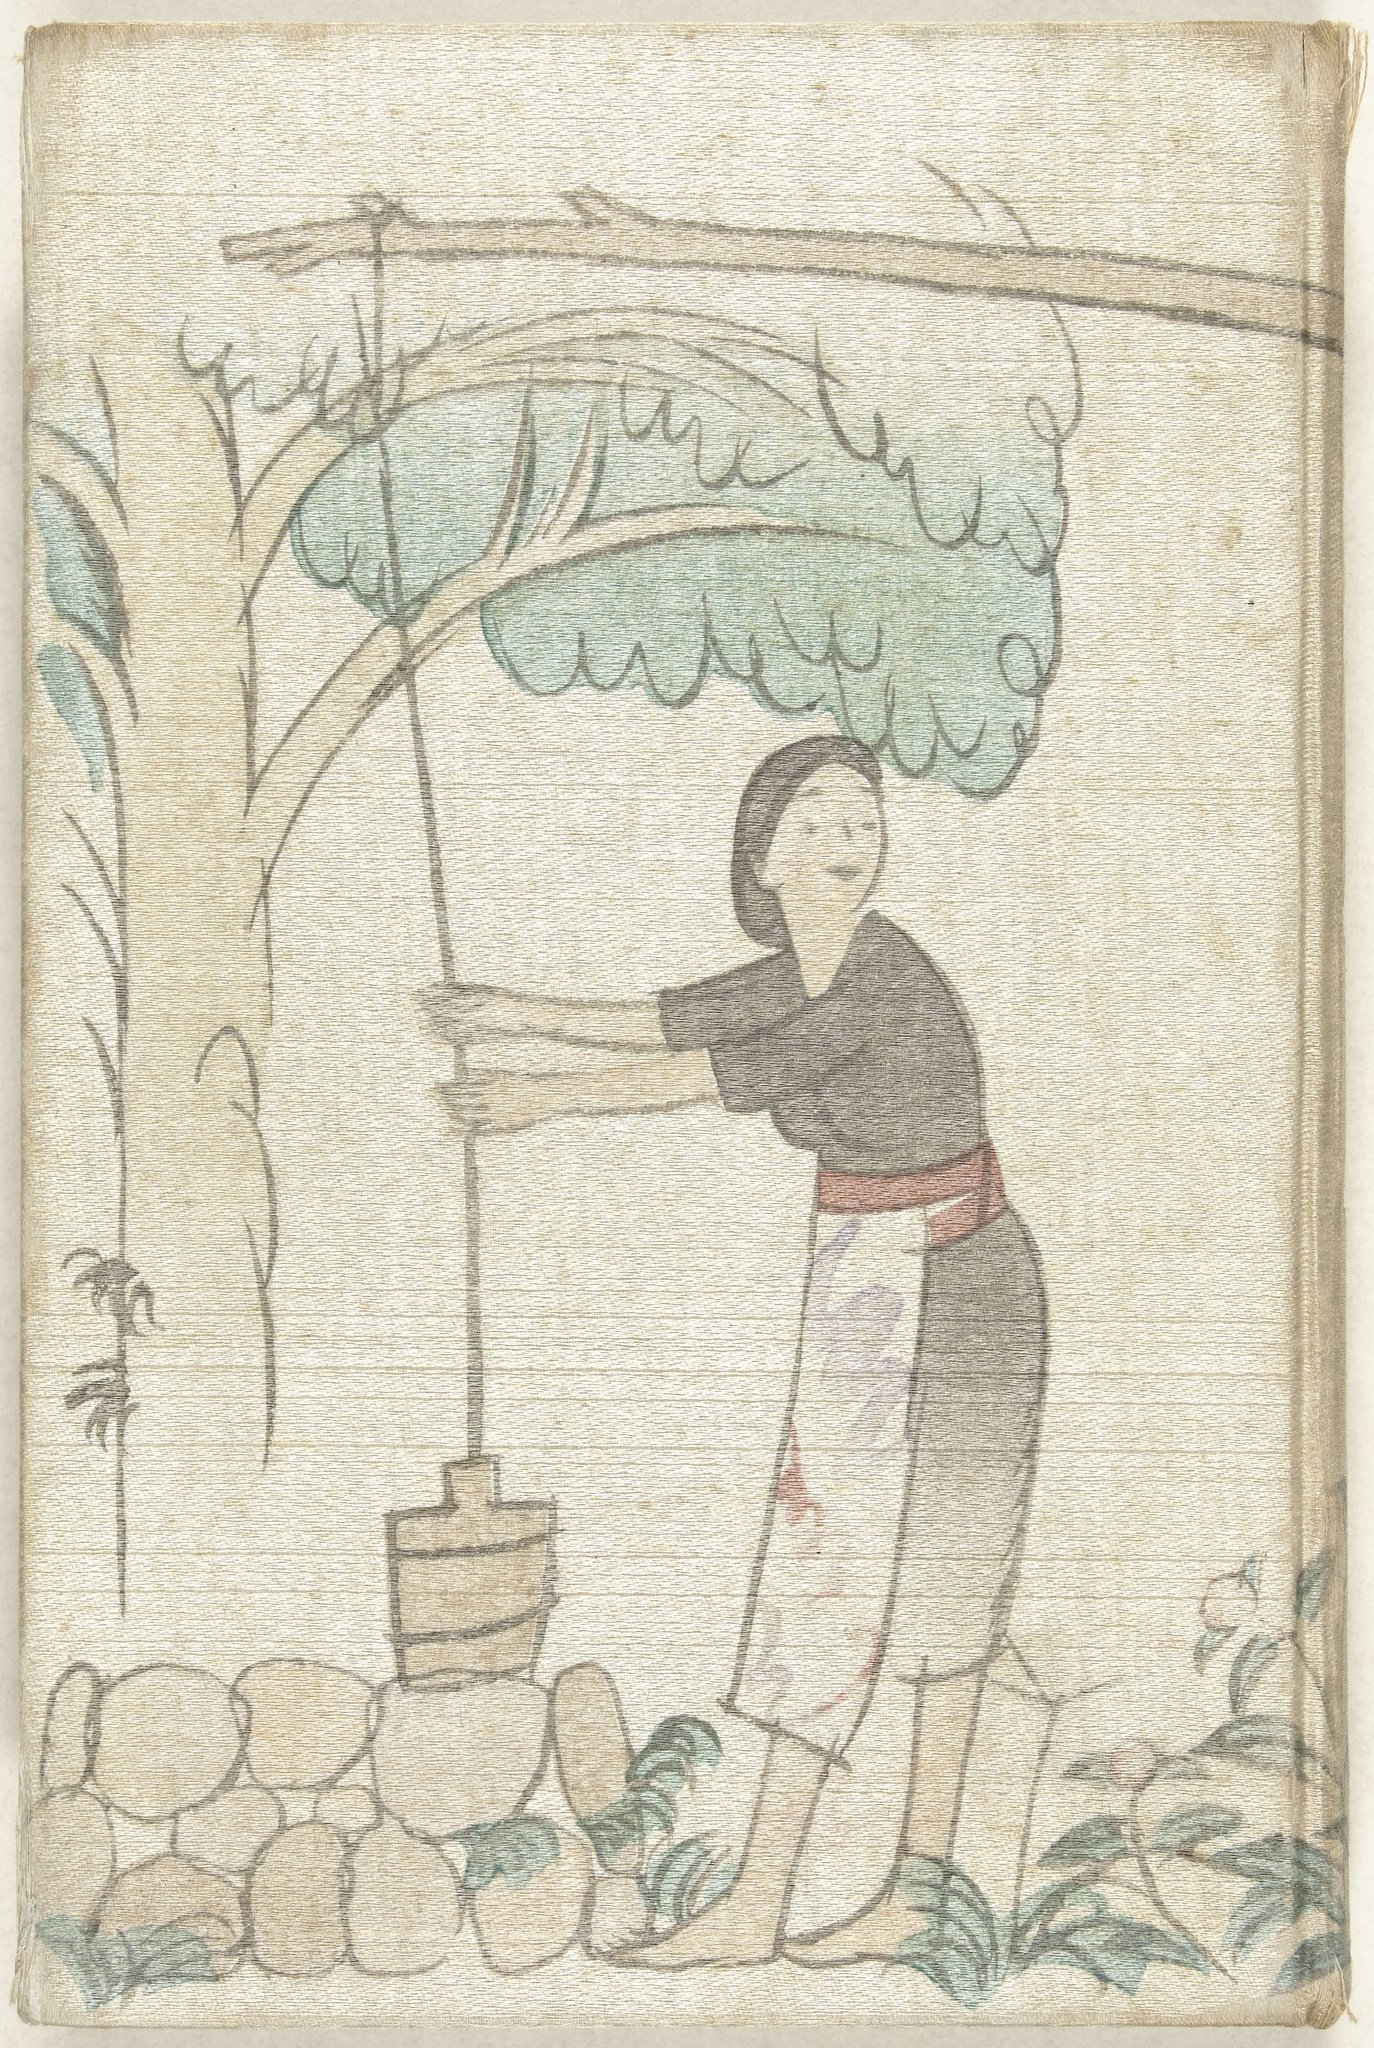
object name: book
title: De inwoners en vegetatie van Musashino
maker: ôta saburô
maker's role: print maker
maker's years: 1884-1969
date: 1909-1920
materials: paper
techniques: woodcut, letterpress printing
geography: japan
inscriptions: mark: ‘kinseido’, mark